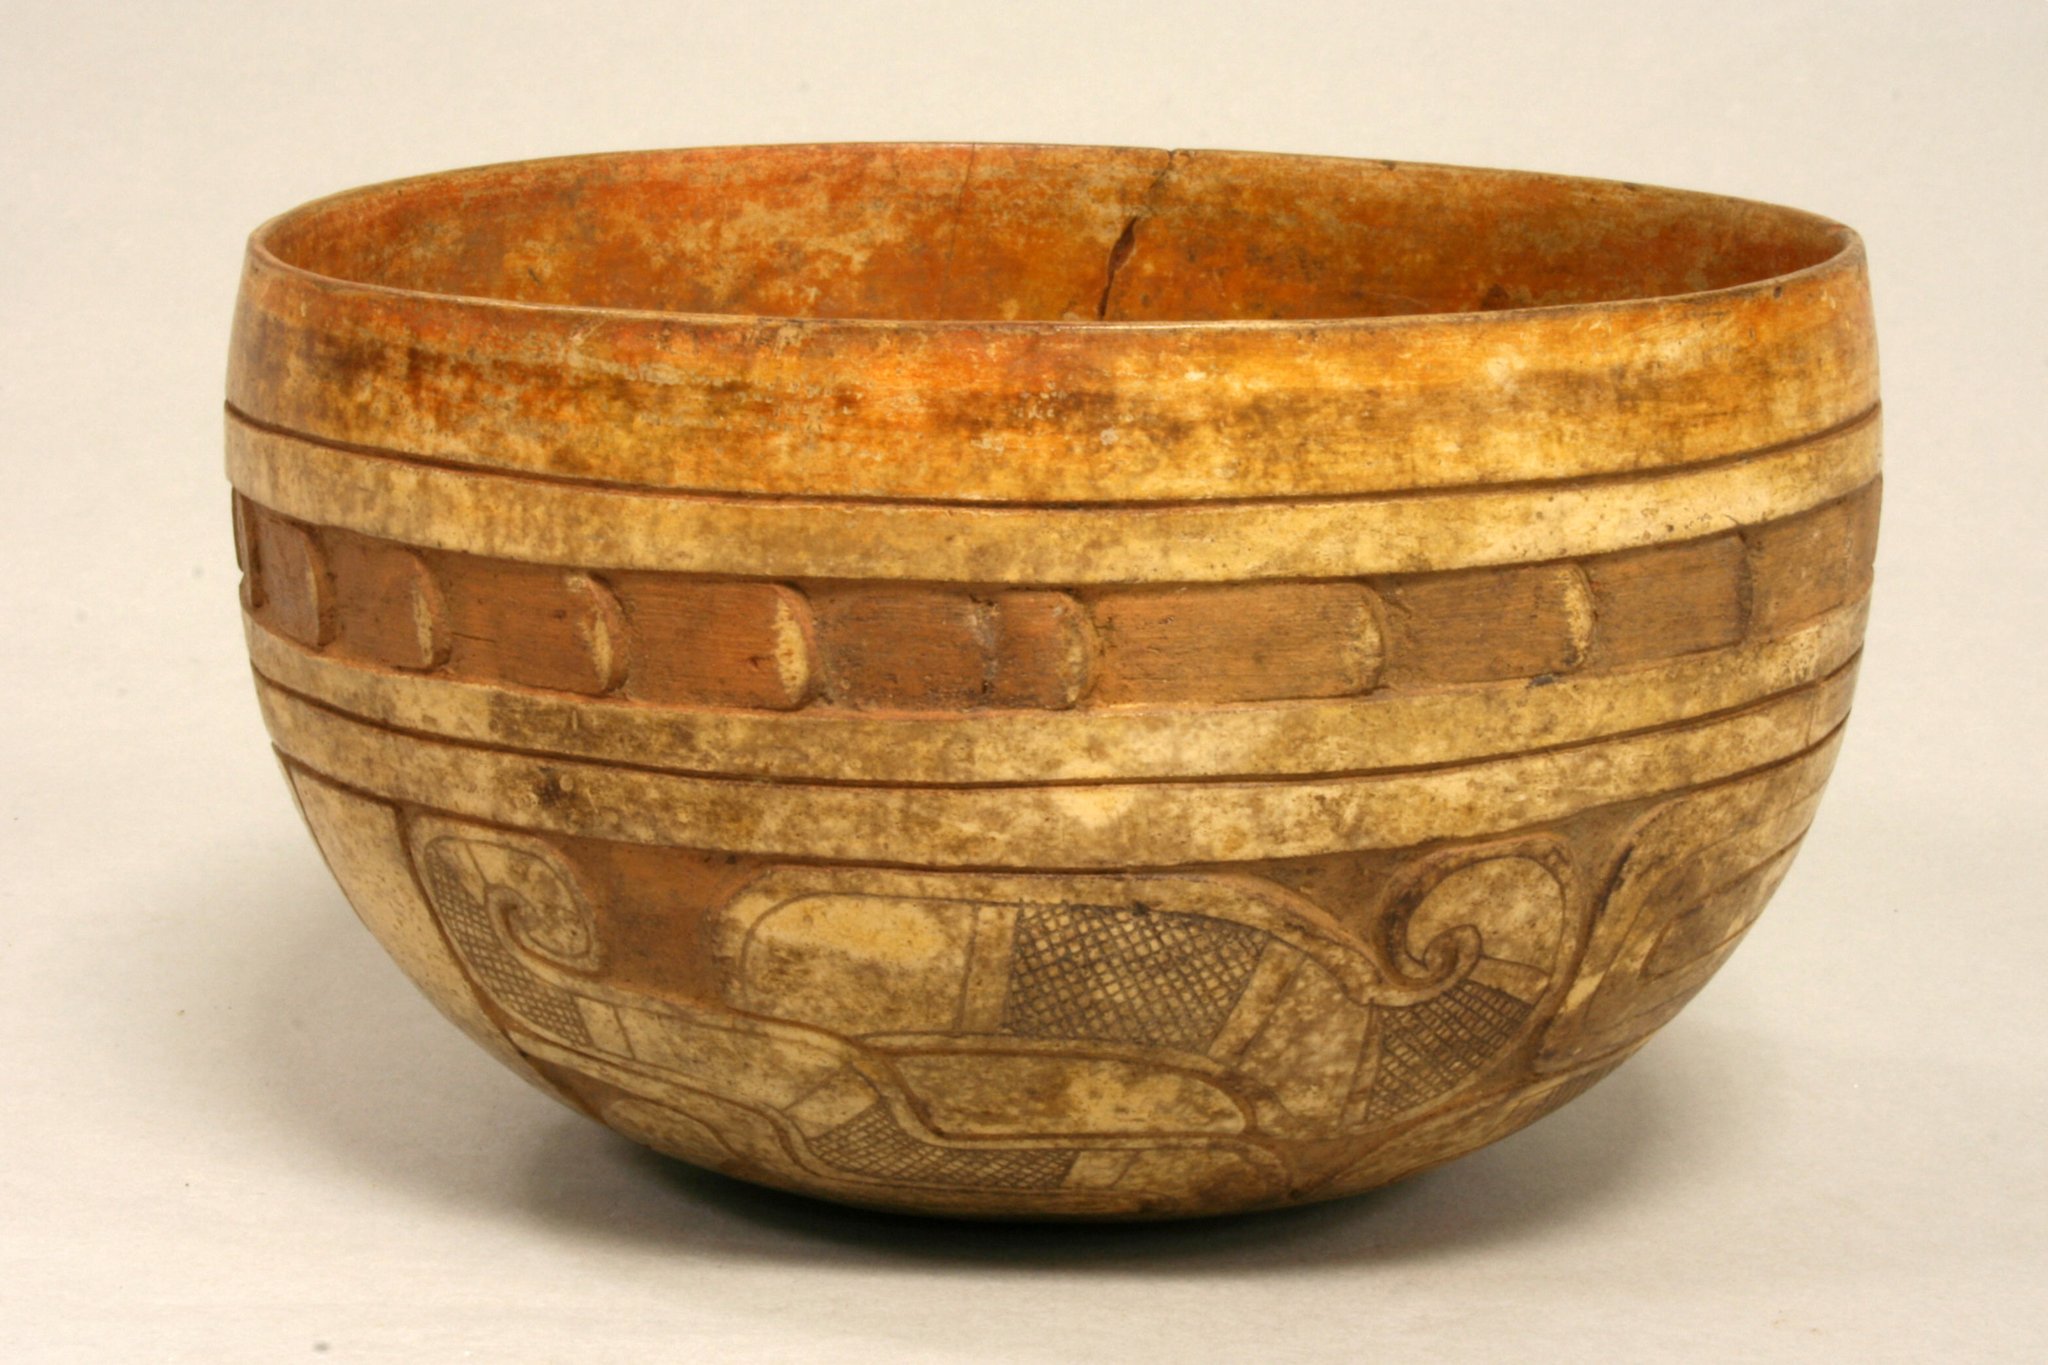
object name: bowl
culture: maya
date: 601-800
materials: ceramic, pigment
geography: guatemala